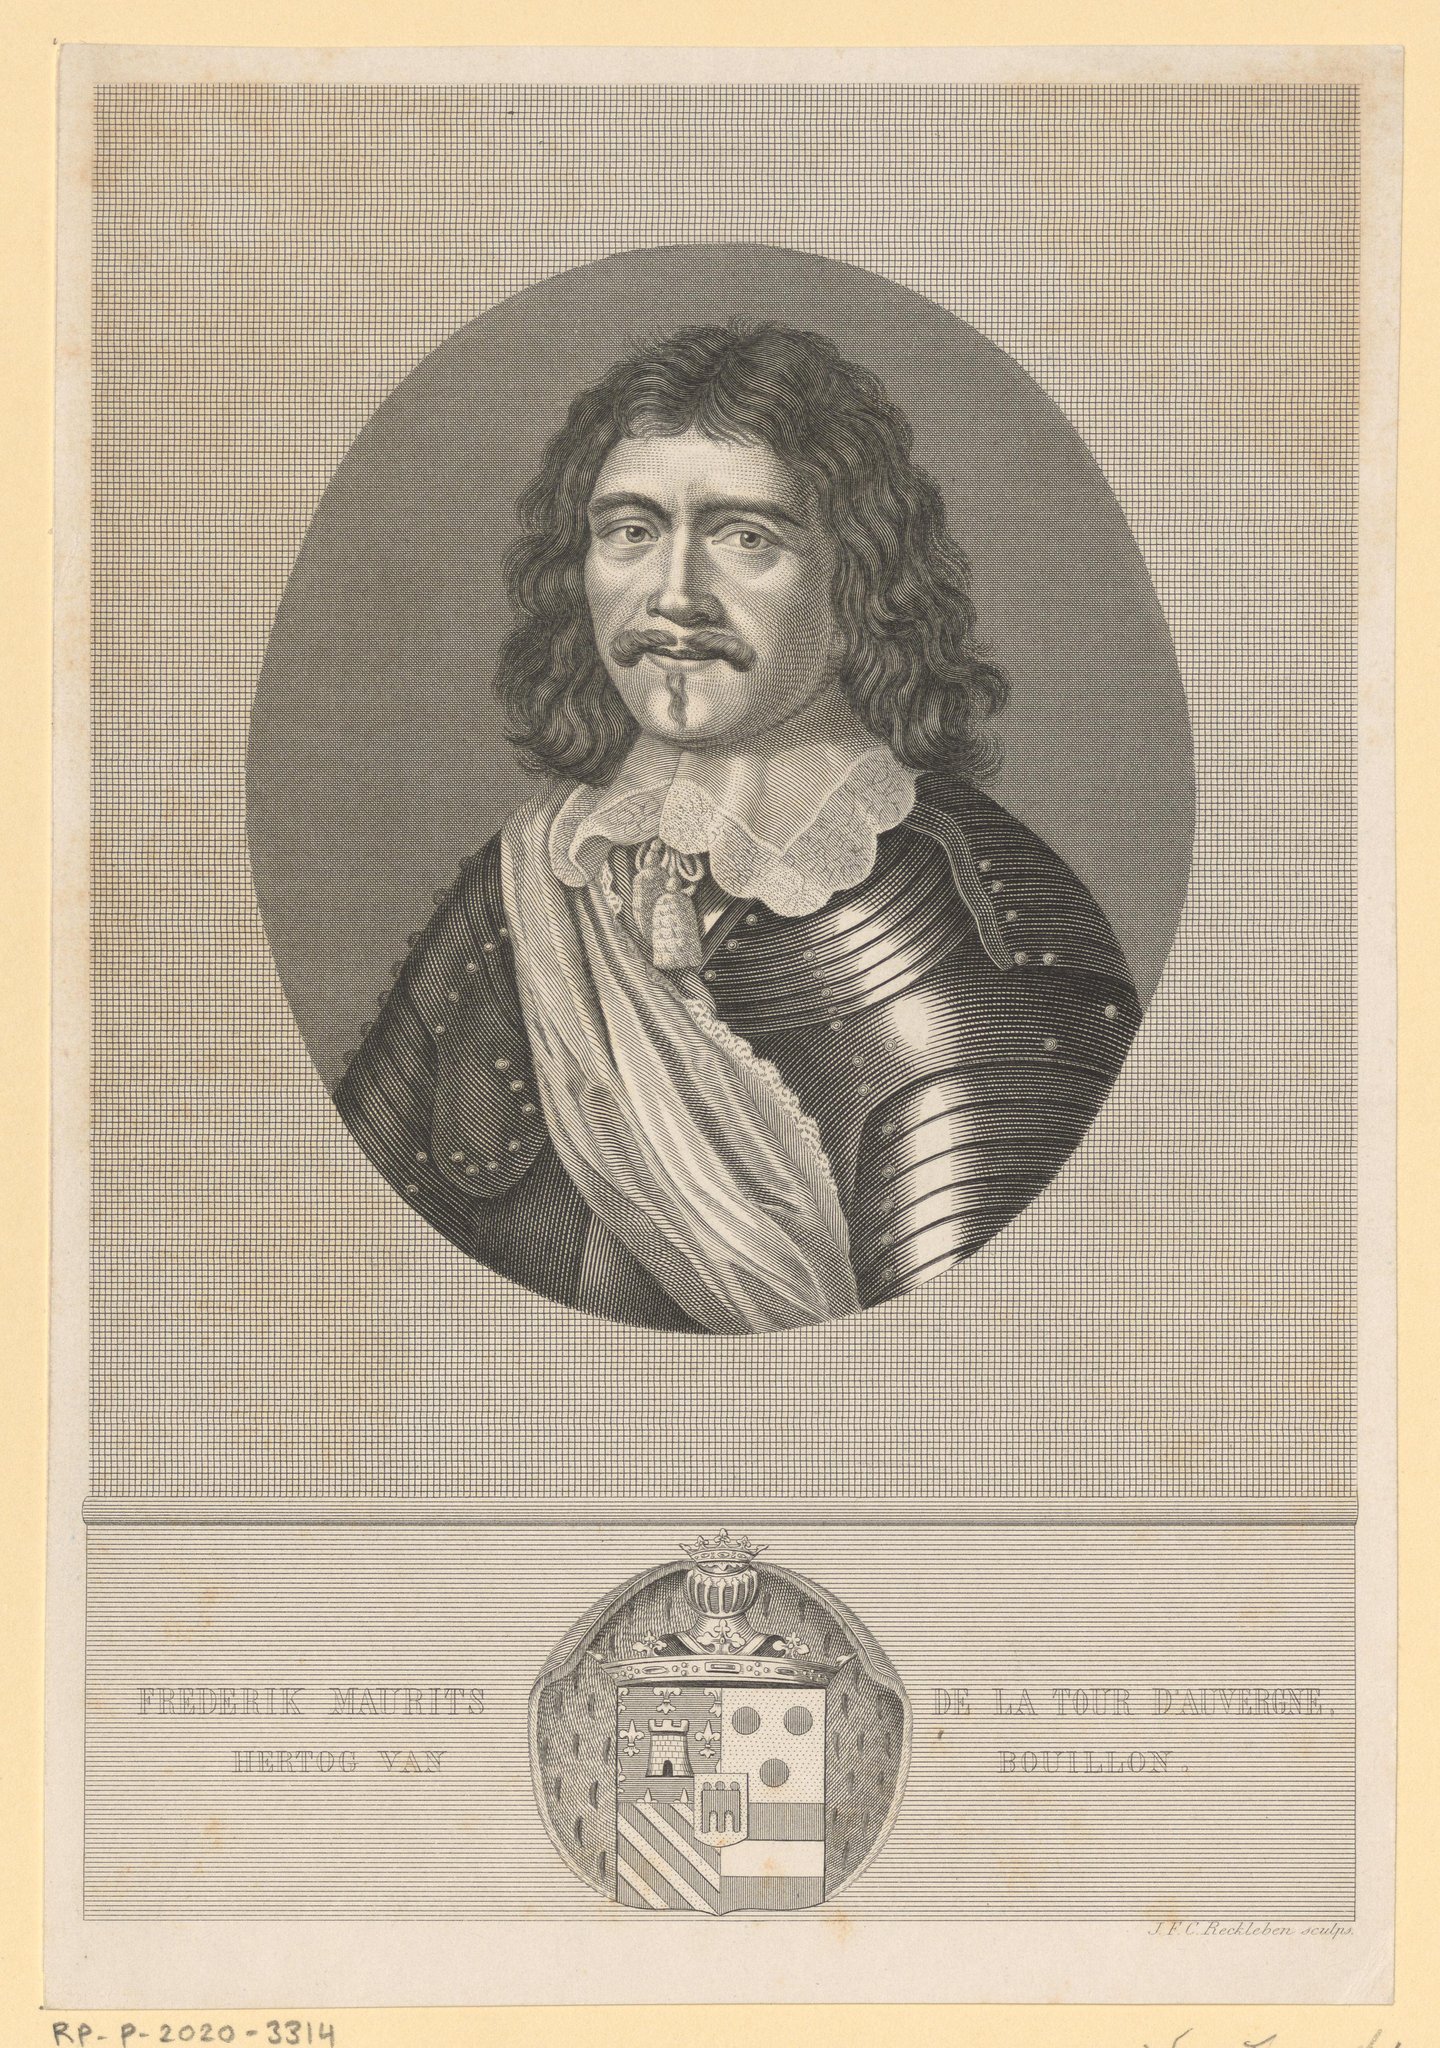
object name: print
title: Portret van Frédéric-Maurice de la Tour d'Auvergne, hertog van Bouillon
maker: jan frederik christiaan reckleben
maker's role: print maker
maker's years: 1819-1879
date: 1868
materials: paper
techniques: engraving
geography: amsterdam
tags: armour, historical persons, armorial bearing, heraldry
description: Prent uit: Arend, Johannes Pieter. Algemeene geschiedenis des vaderlands van de vroegste tijden tot op heden. Amsterdam: C. Schleijer en zoon, 1868, dl. 3-5.